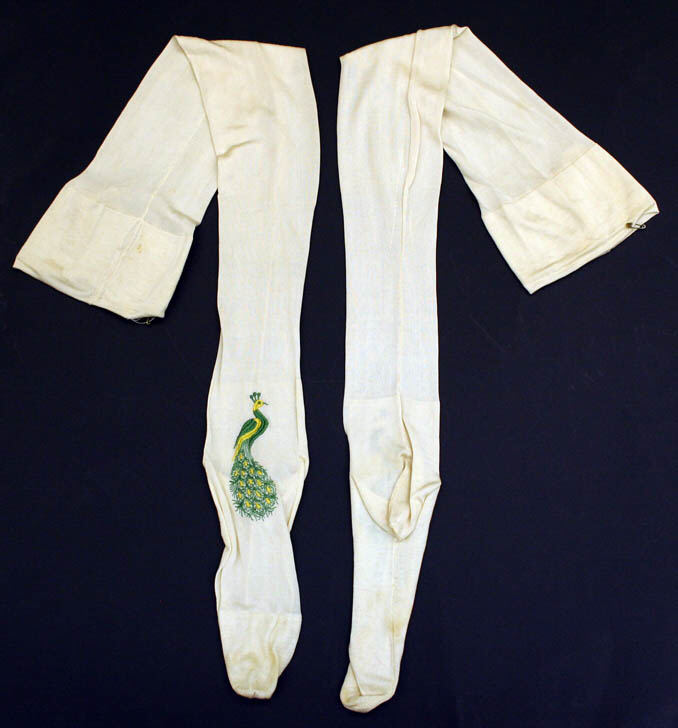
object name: stocking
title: Stockings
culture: french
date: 1875-1899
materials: cotton, silk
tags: peacocks